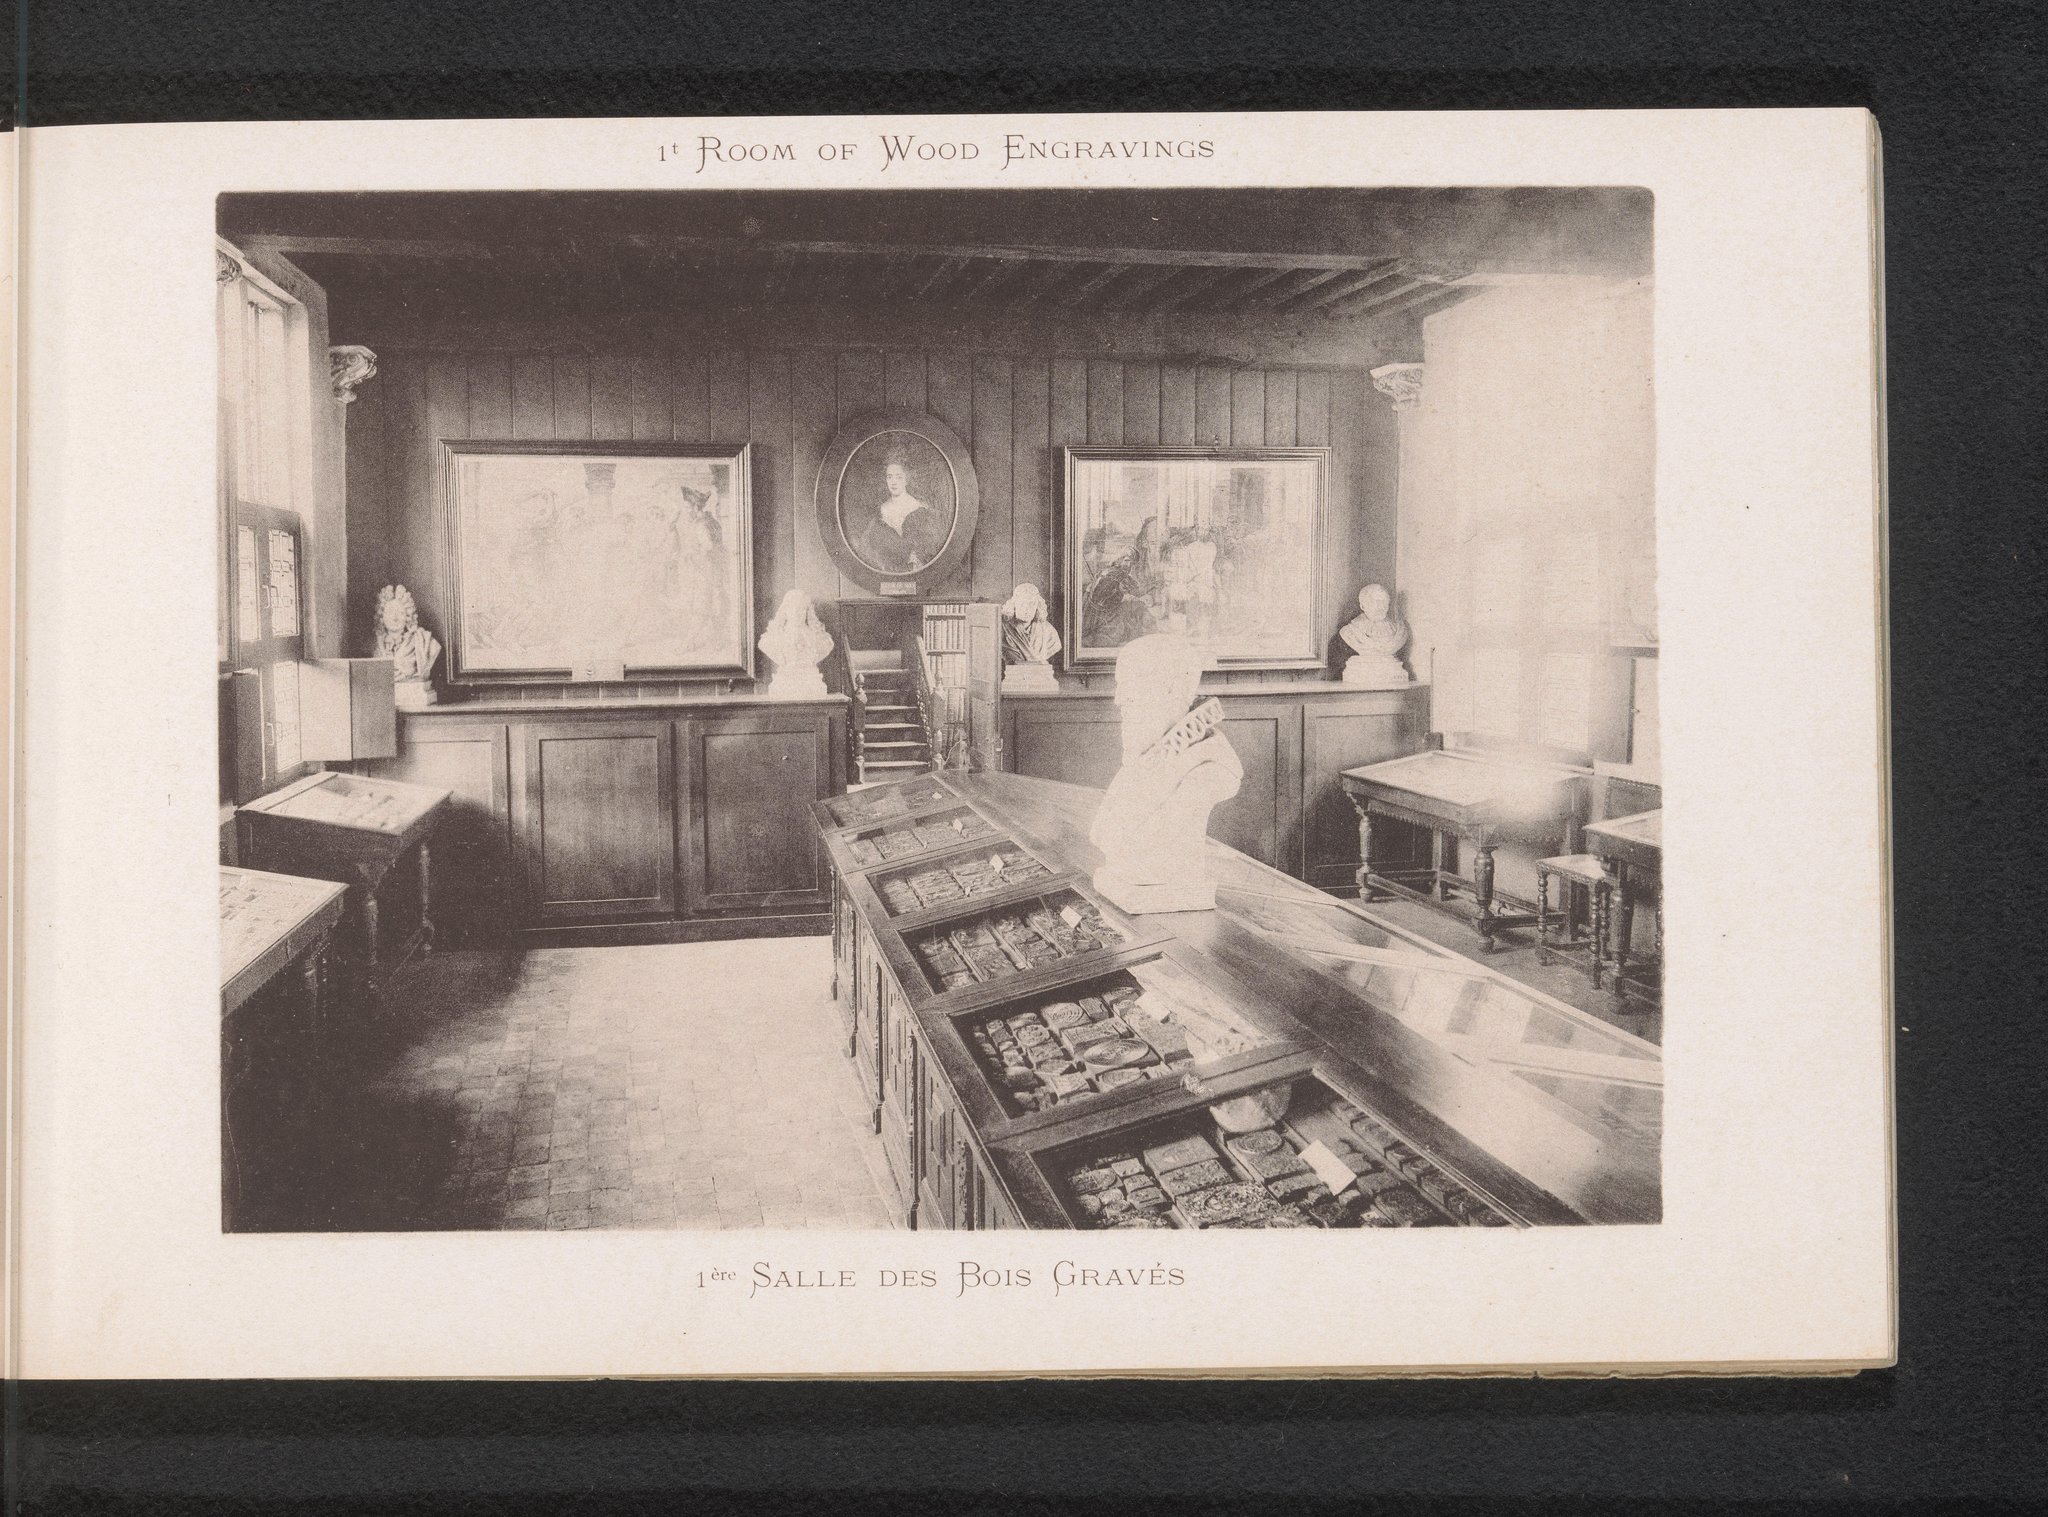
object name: photomechanical print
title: Zaal met houtgravures en gegraveerd hout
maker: Anonymous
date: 1892-1897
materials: paper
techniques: photograph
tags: permanent exhibition, museum, print, e.g.: engraving, etching, lithograph (+ stadia of production of work of art)